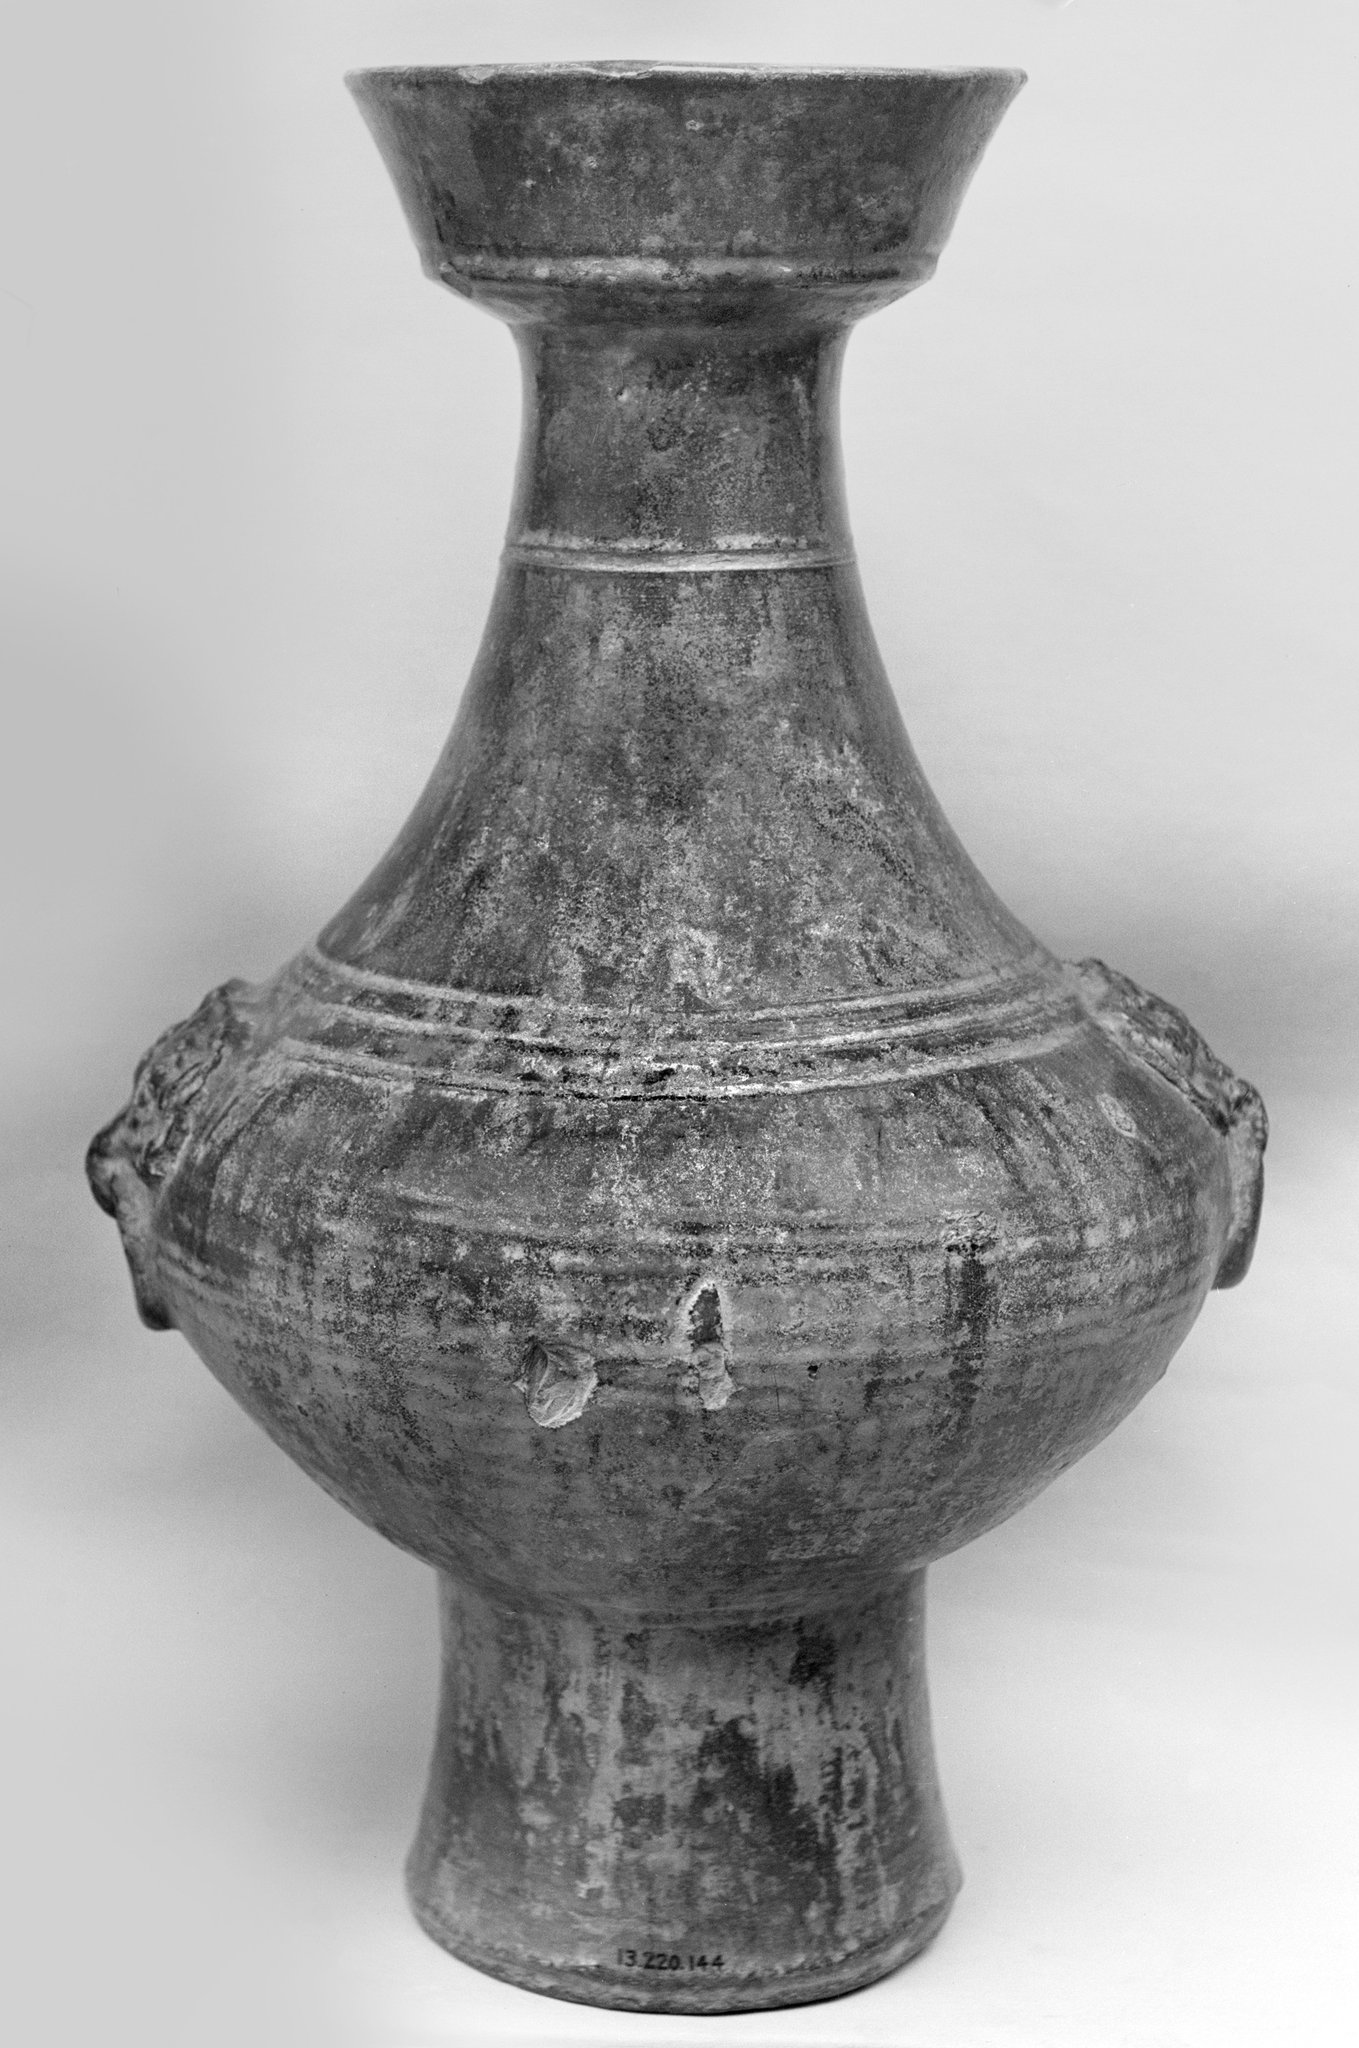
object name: wine container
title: Wine container (hu)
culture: chinese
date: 1-200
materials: glaze, lead